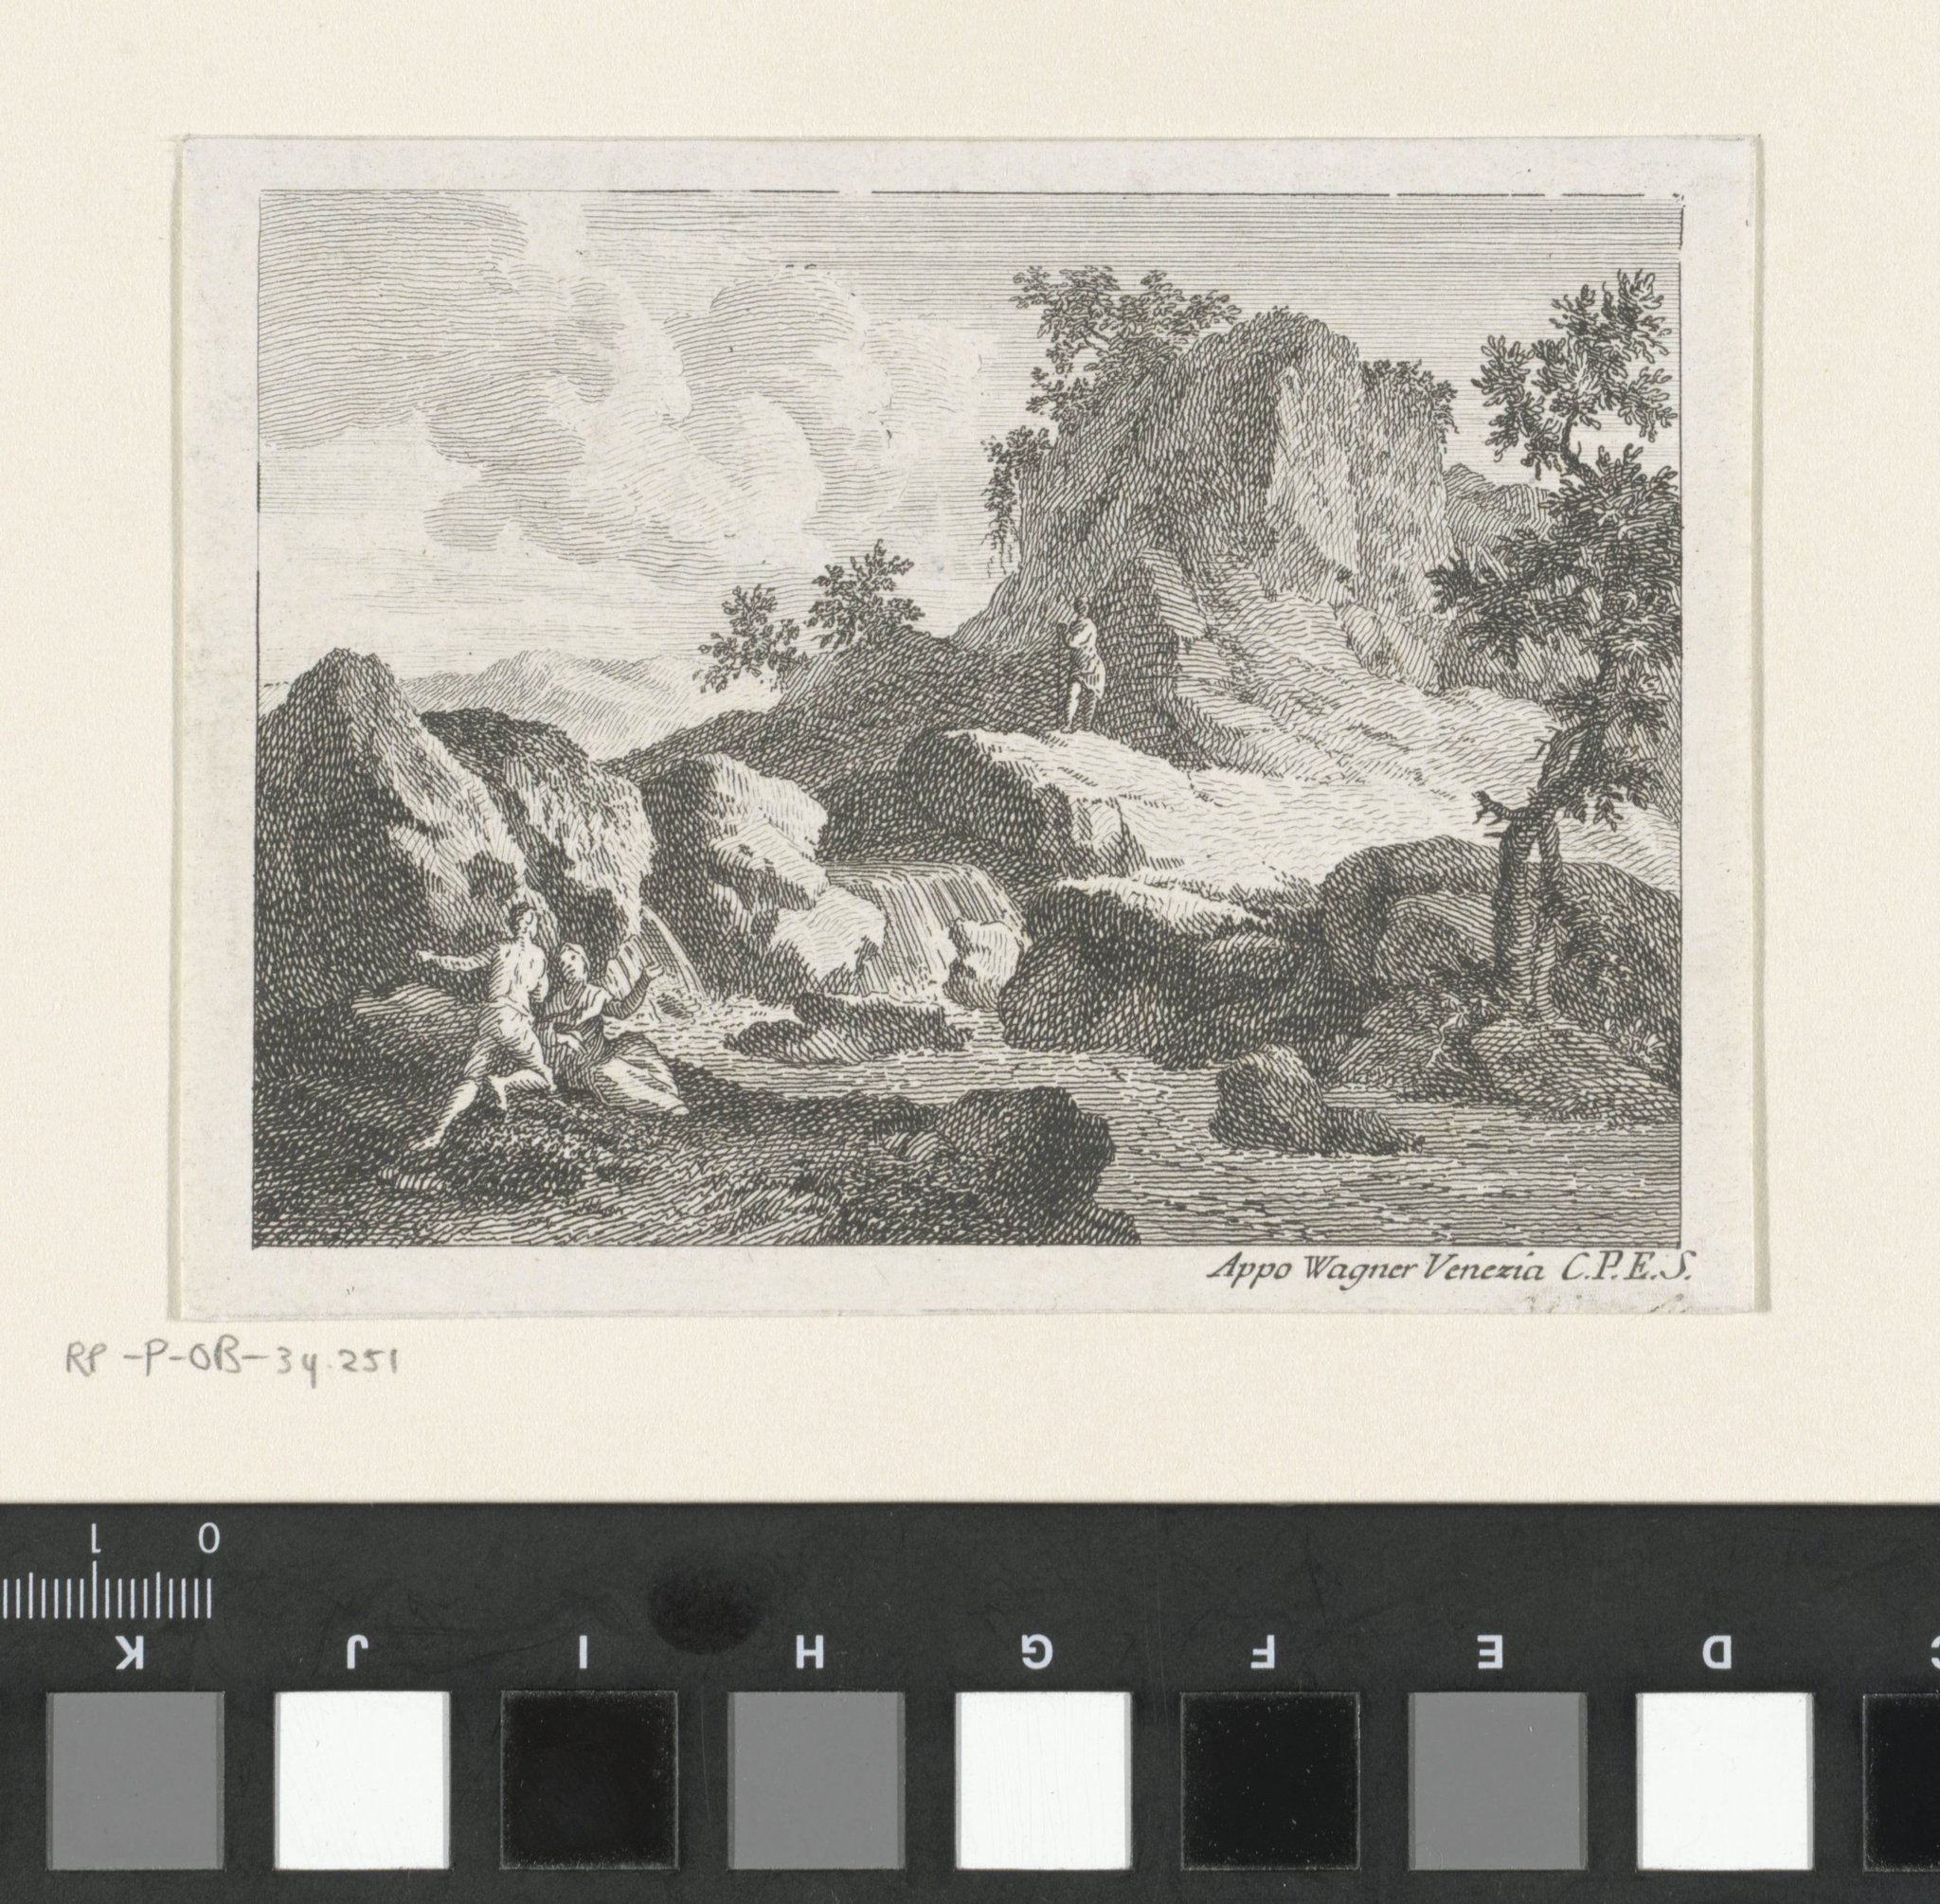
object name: print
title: Landschap met drie figuren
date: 1739-1780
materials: paper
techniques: engraving, etching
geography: venice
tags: landscapes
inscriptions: collector's mark: Lugt 240